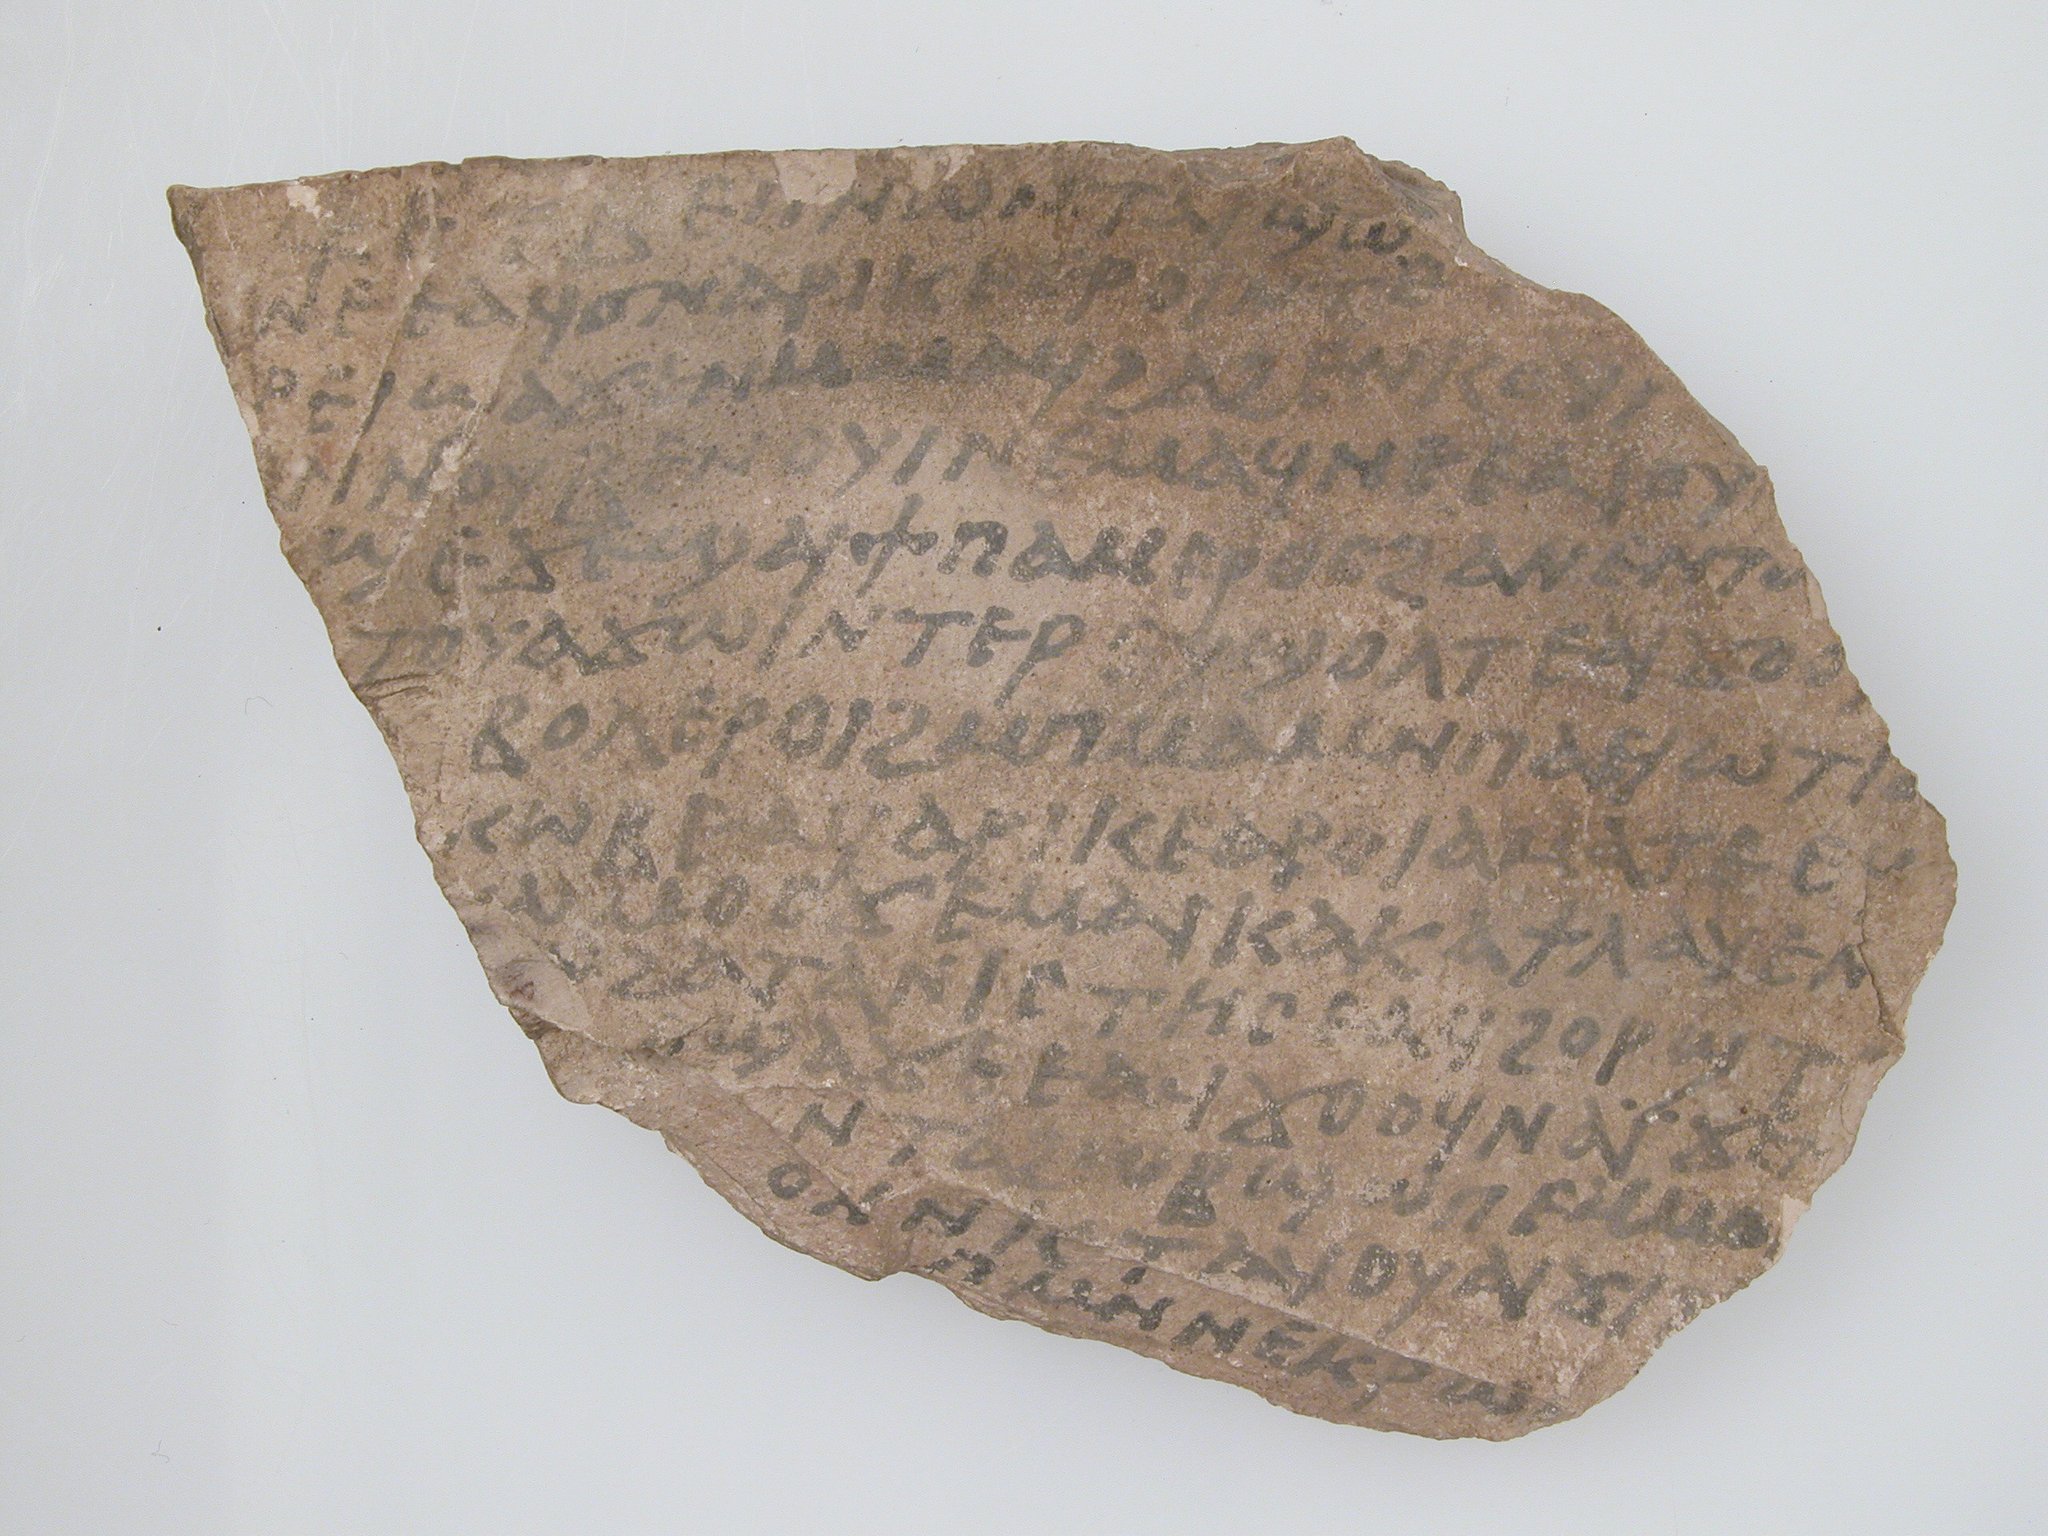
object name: ostrakon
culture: coptic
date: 601-700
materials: ink, limestone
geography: egypt